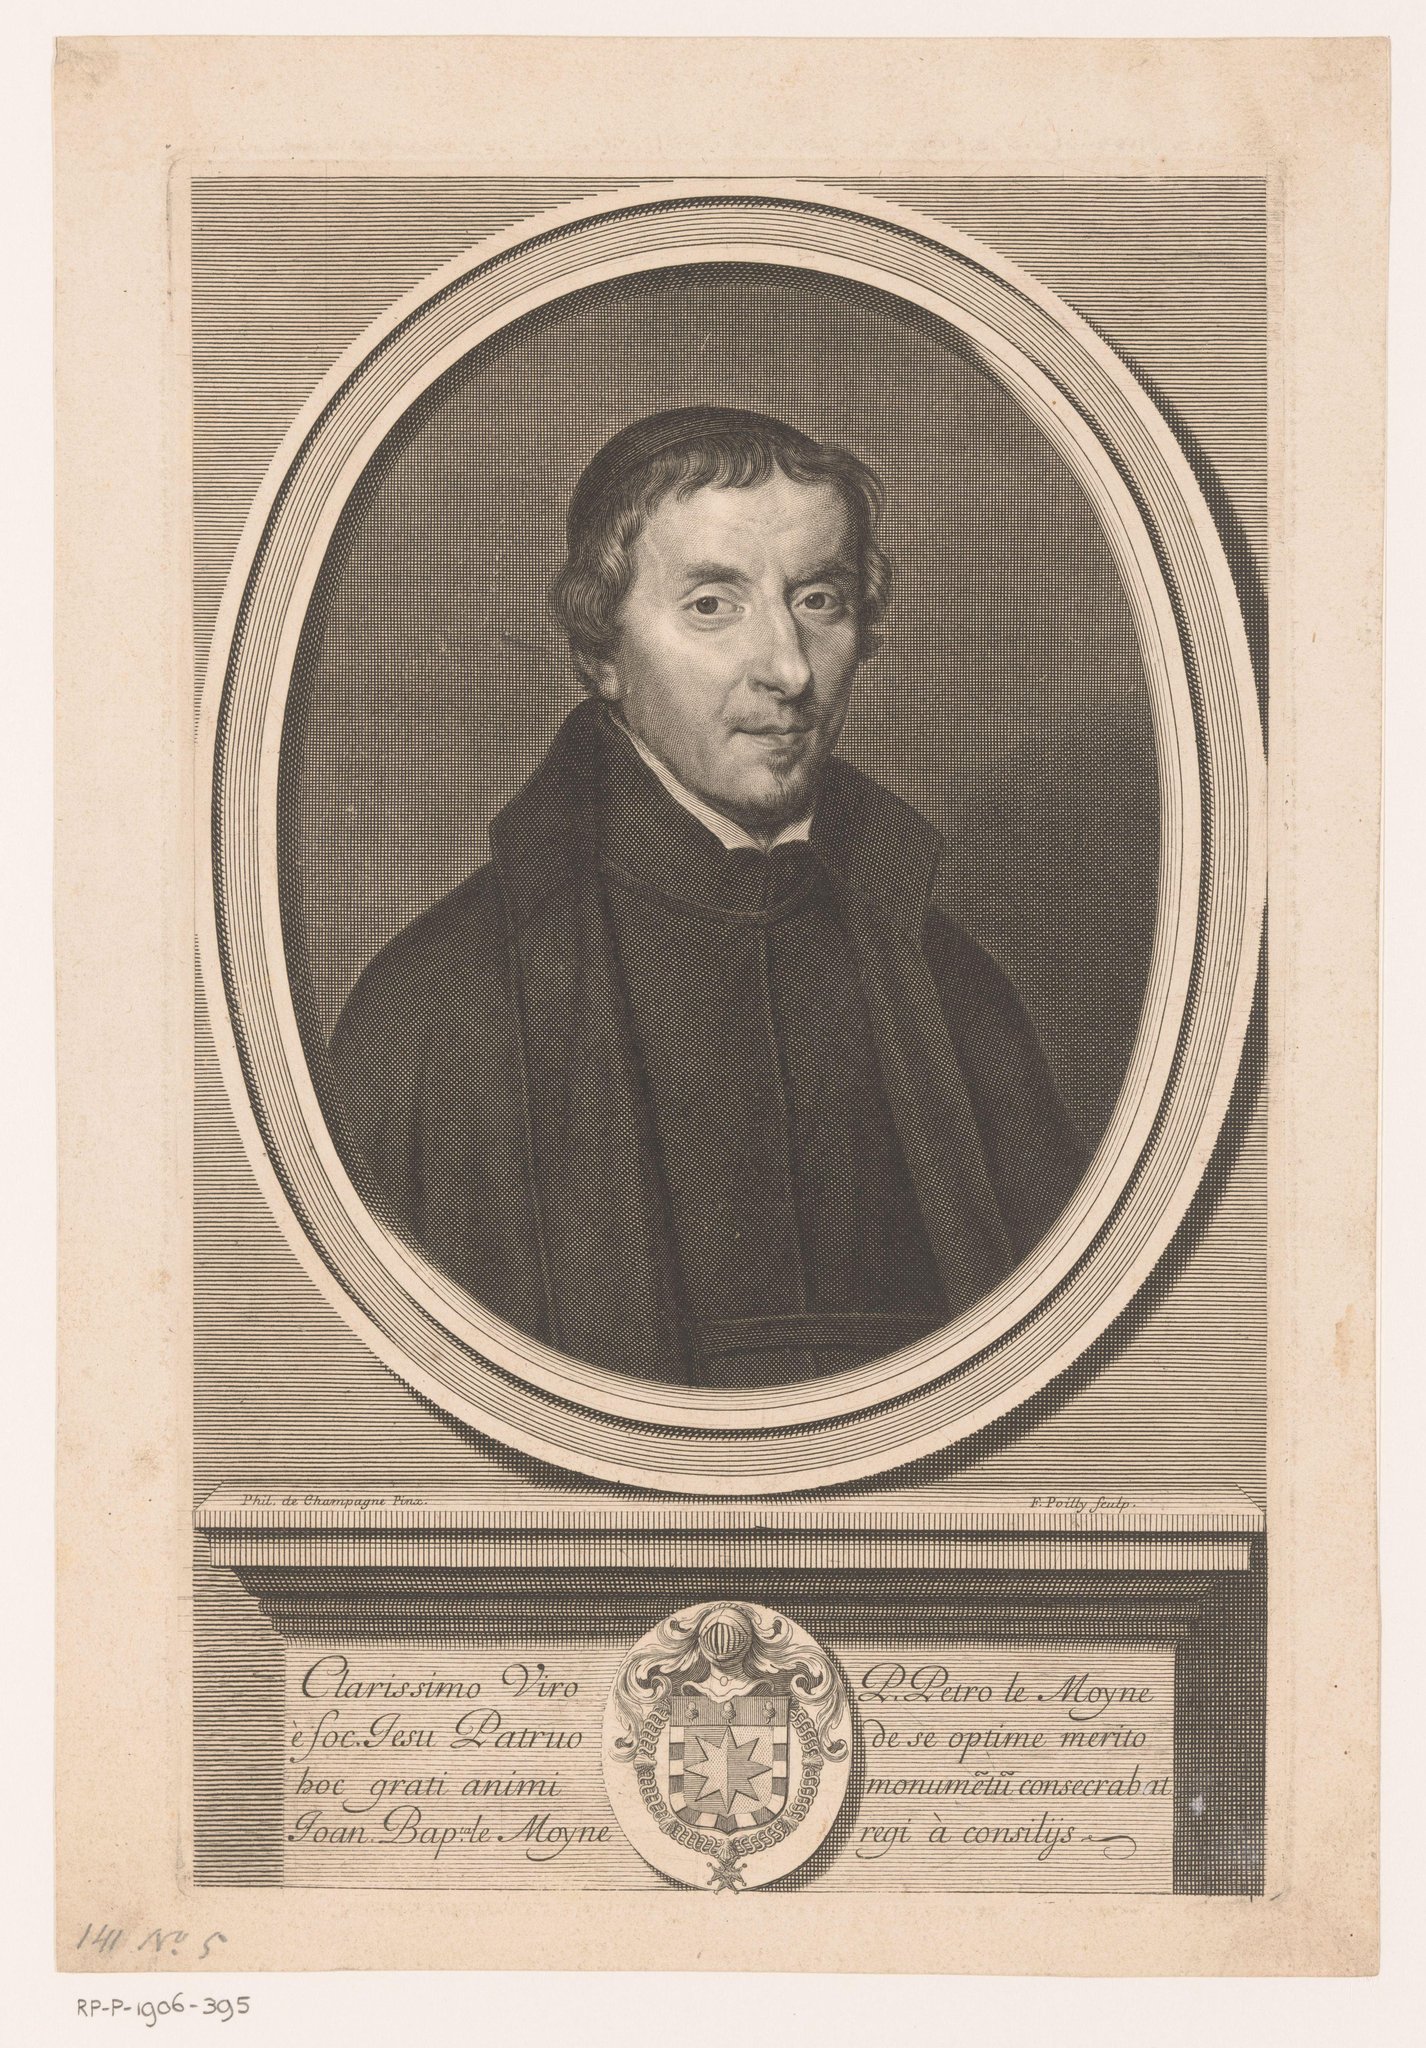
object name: print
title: Portret van Pierre Le Moyne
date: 1632-1693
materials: paper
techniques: engraving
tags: paris, historical persons, regular clerics, e.g. jesuits, redemptorists, writer, poet, author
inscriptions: collector's mark: Lugt 2228